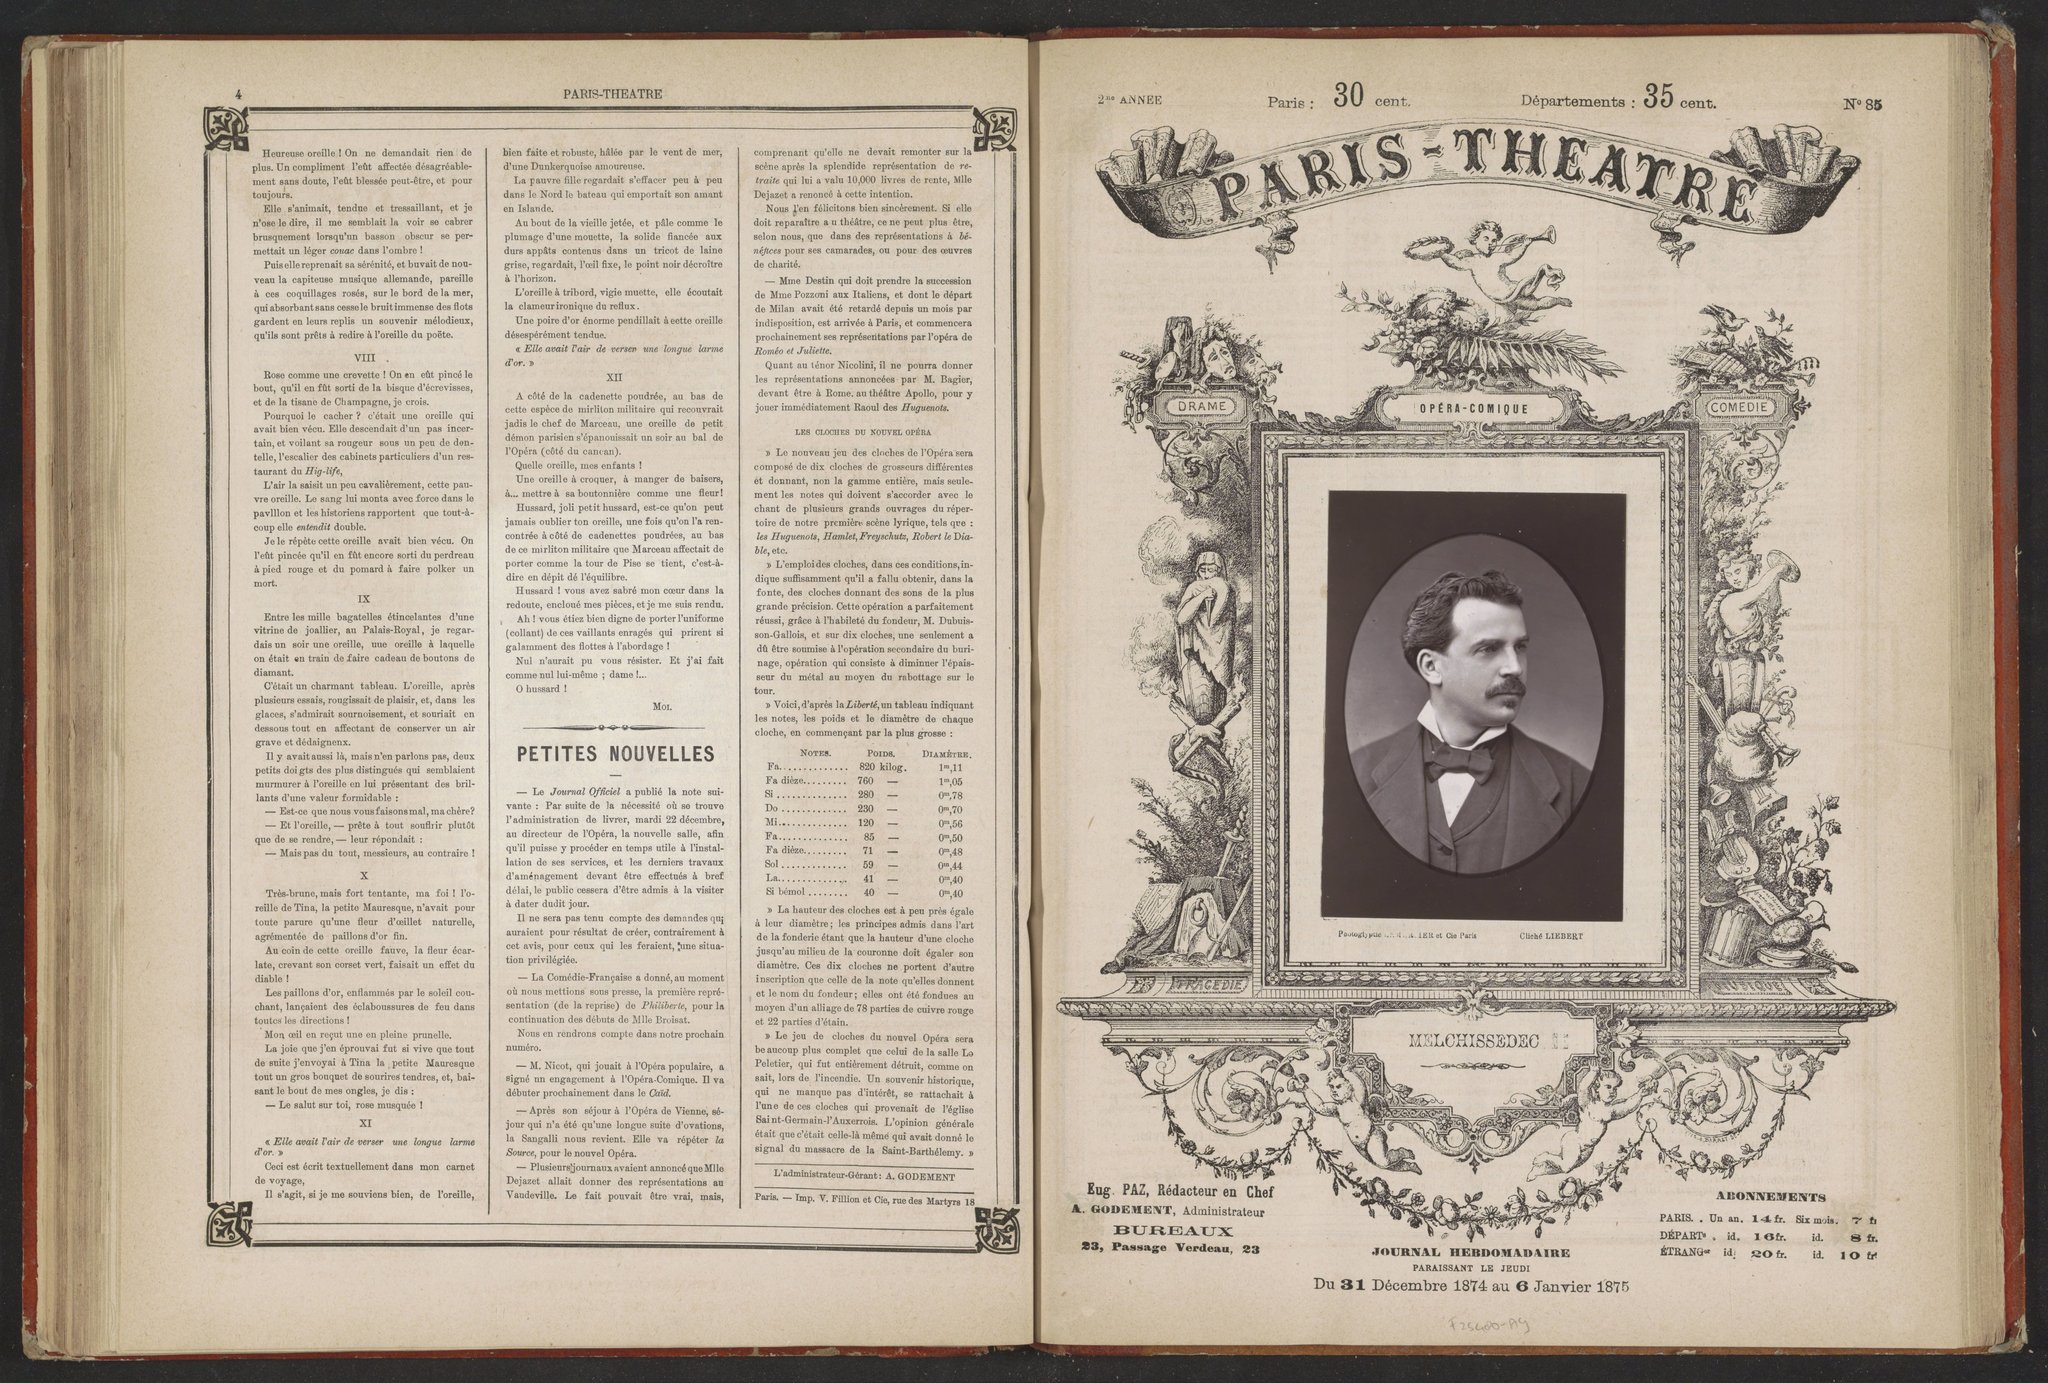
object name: photomechanical print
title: Portret van Léon Melchissédec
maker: alphonse-justin liébert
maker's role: fotograaf, marinier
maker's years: 1827-1914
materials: paper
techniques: woodburytype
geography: paris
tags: portrait of opera-singer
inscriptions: inscription: ‘Journal hebdomadaire paraissant le jeudi Du 31 Décembre 1874 au 6 Janvier 1875’, number: ‘No 85’